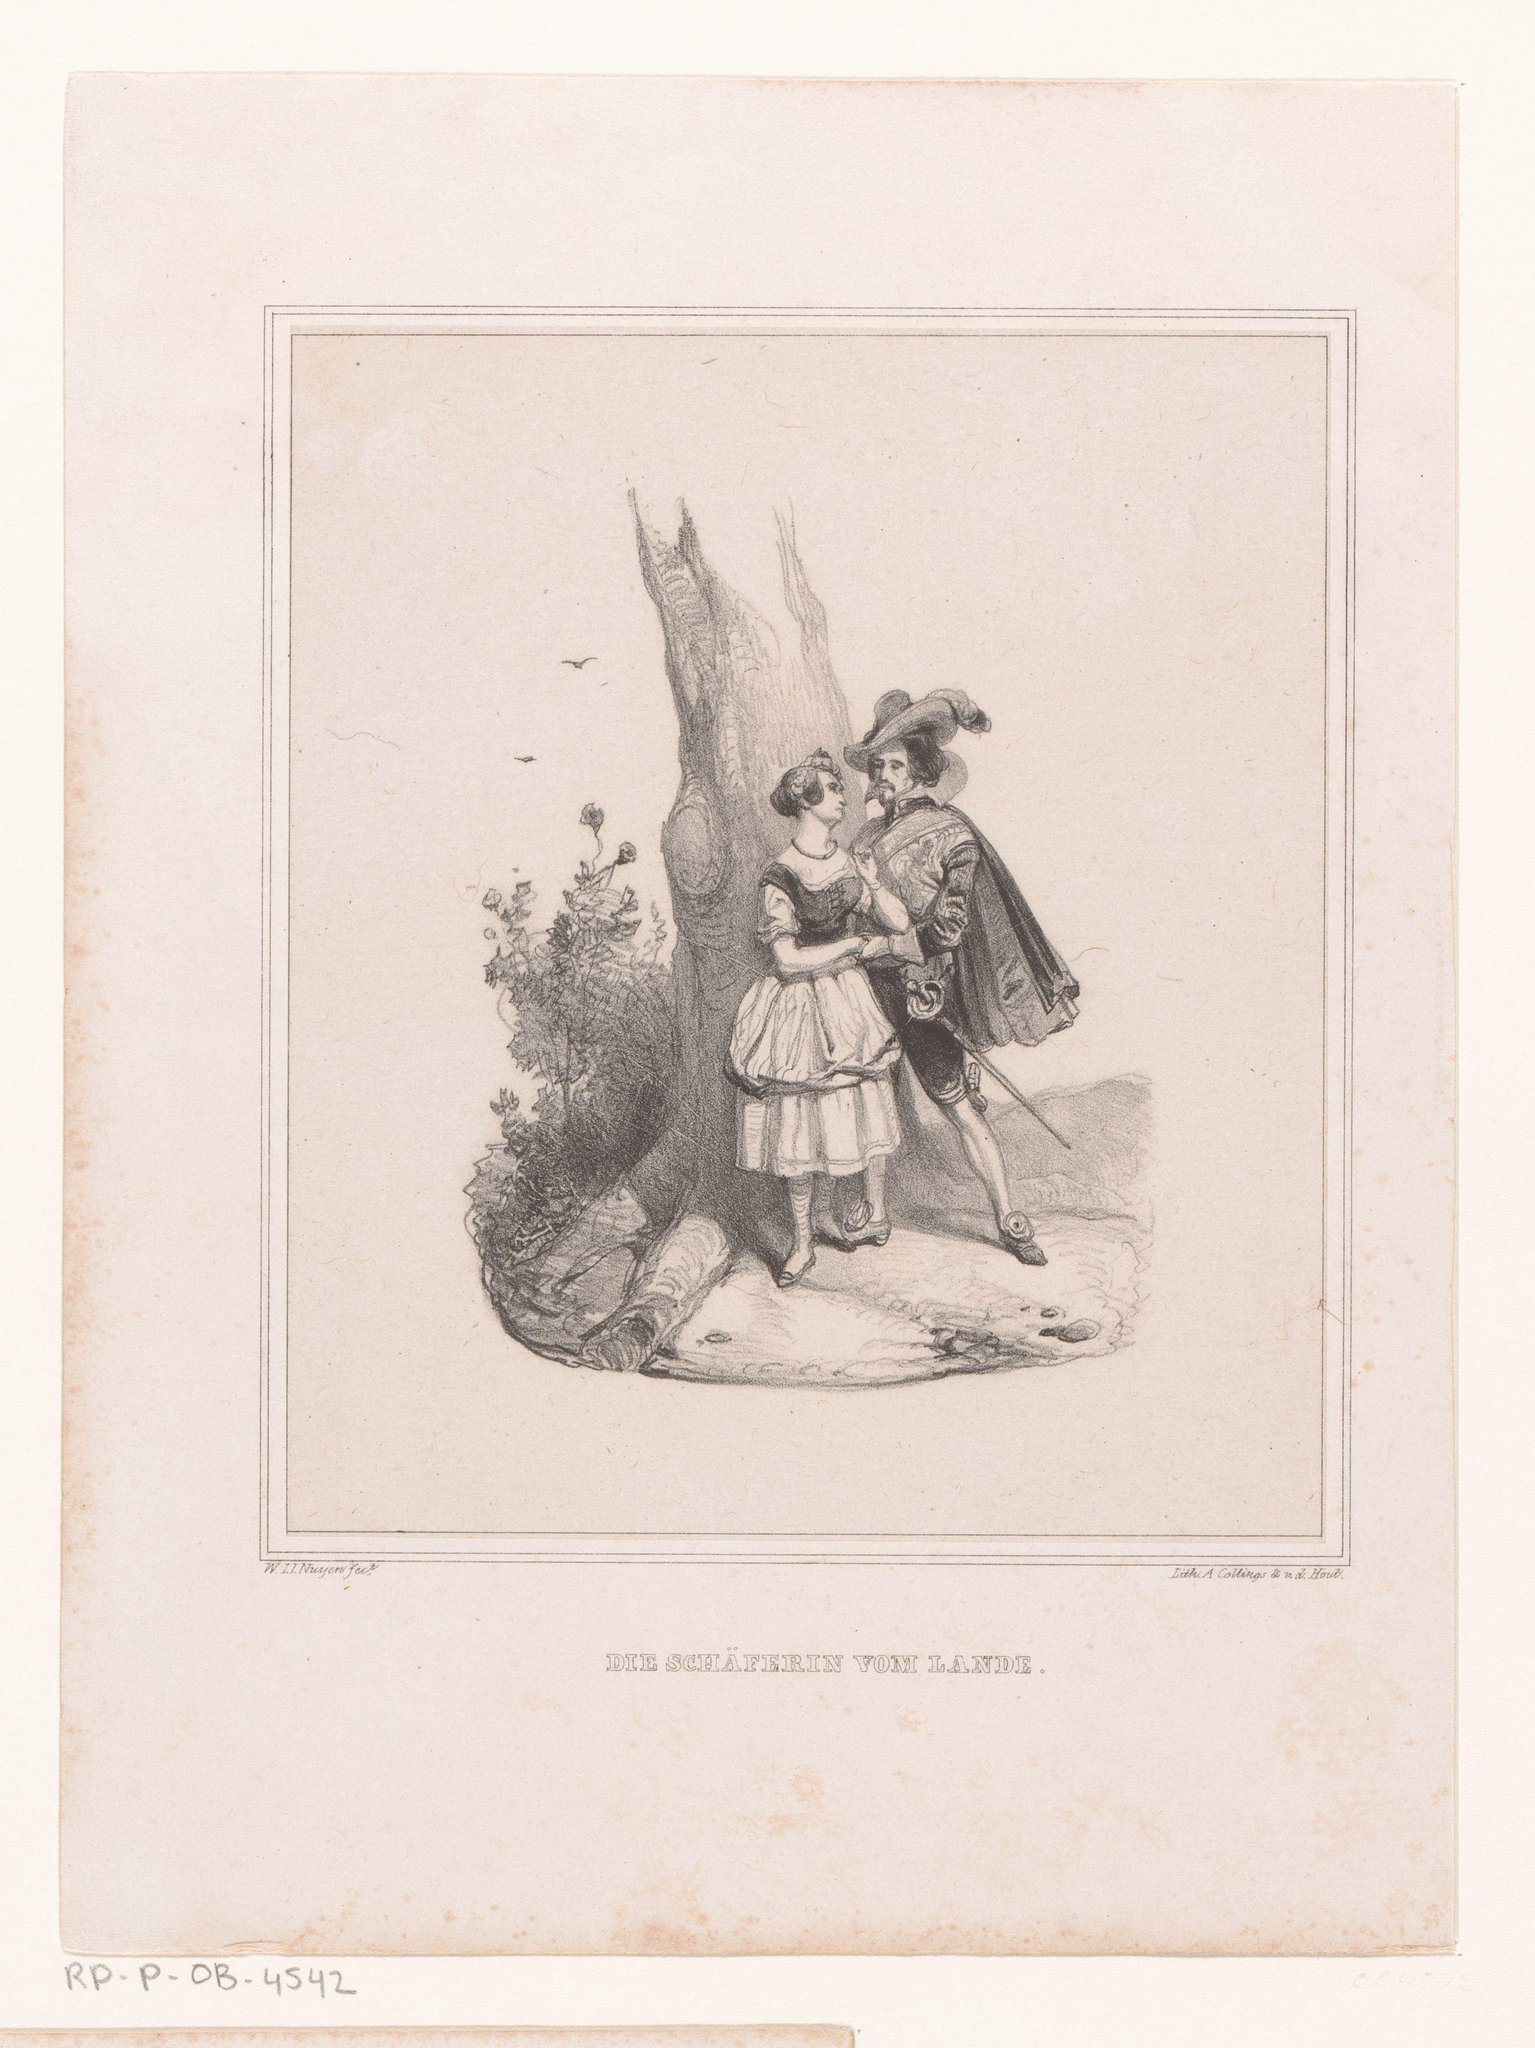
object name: print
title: Die Schäferin vom Lande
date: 1823-1839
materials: paper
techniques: lithograph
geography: rotterdam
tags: couple of lovers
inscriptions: collector's mark: Lugt 2228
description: Een man en vrouw staan in een landschap voor een boom.